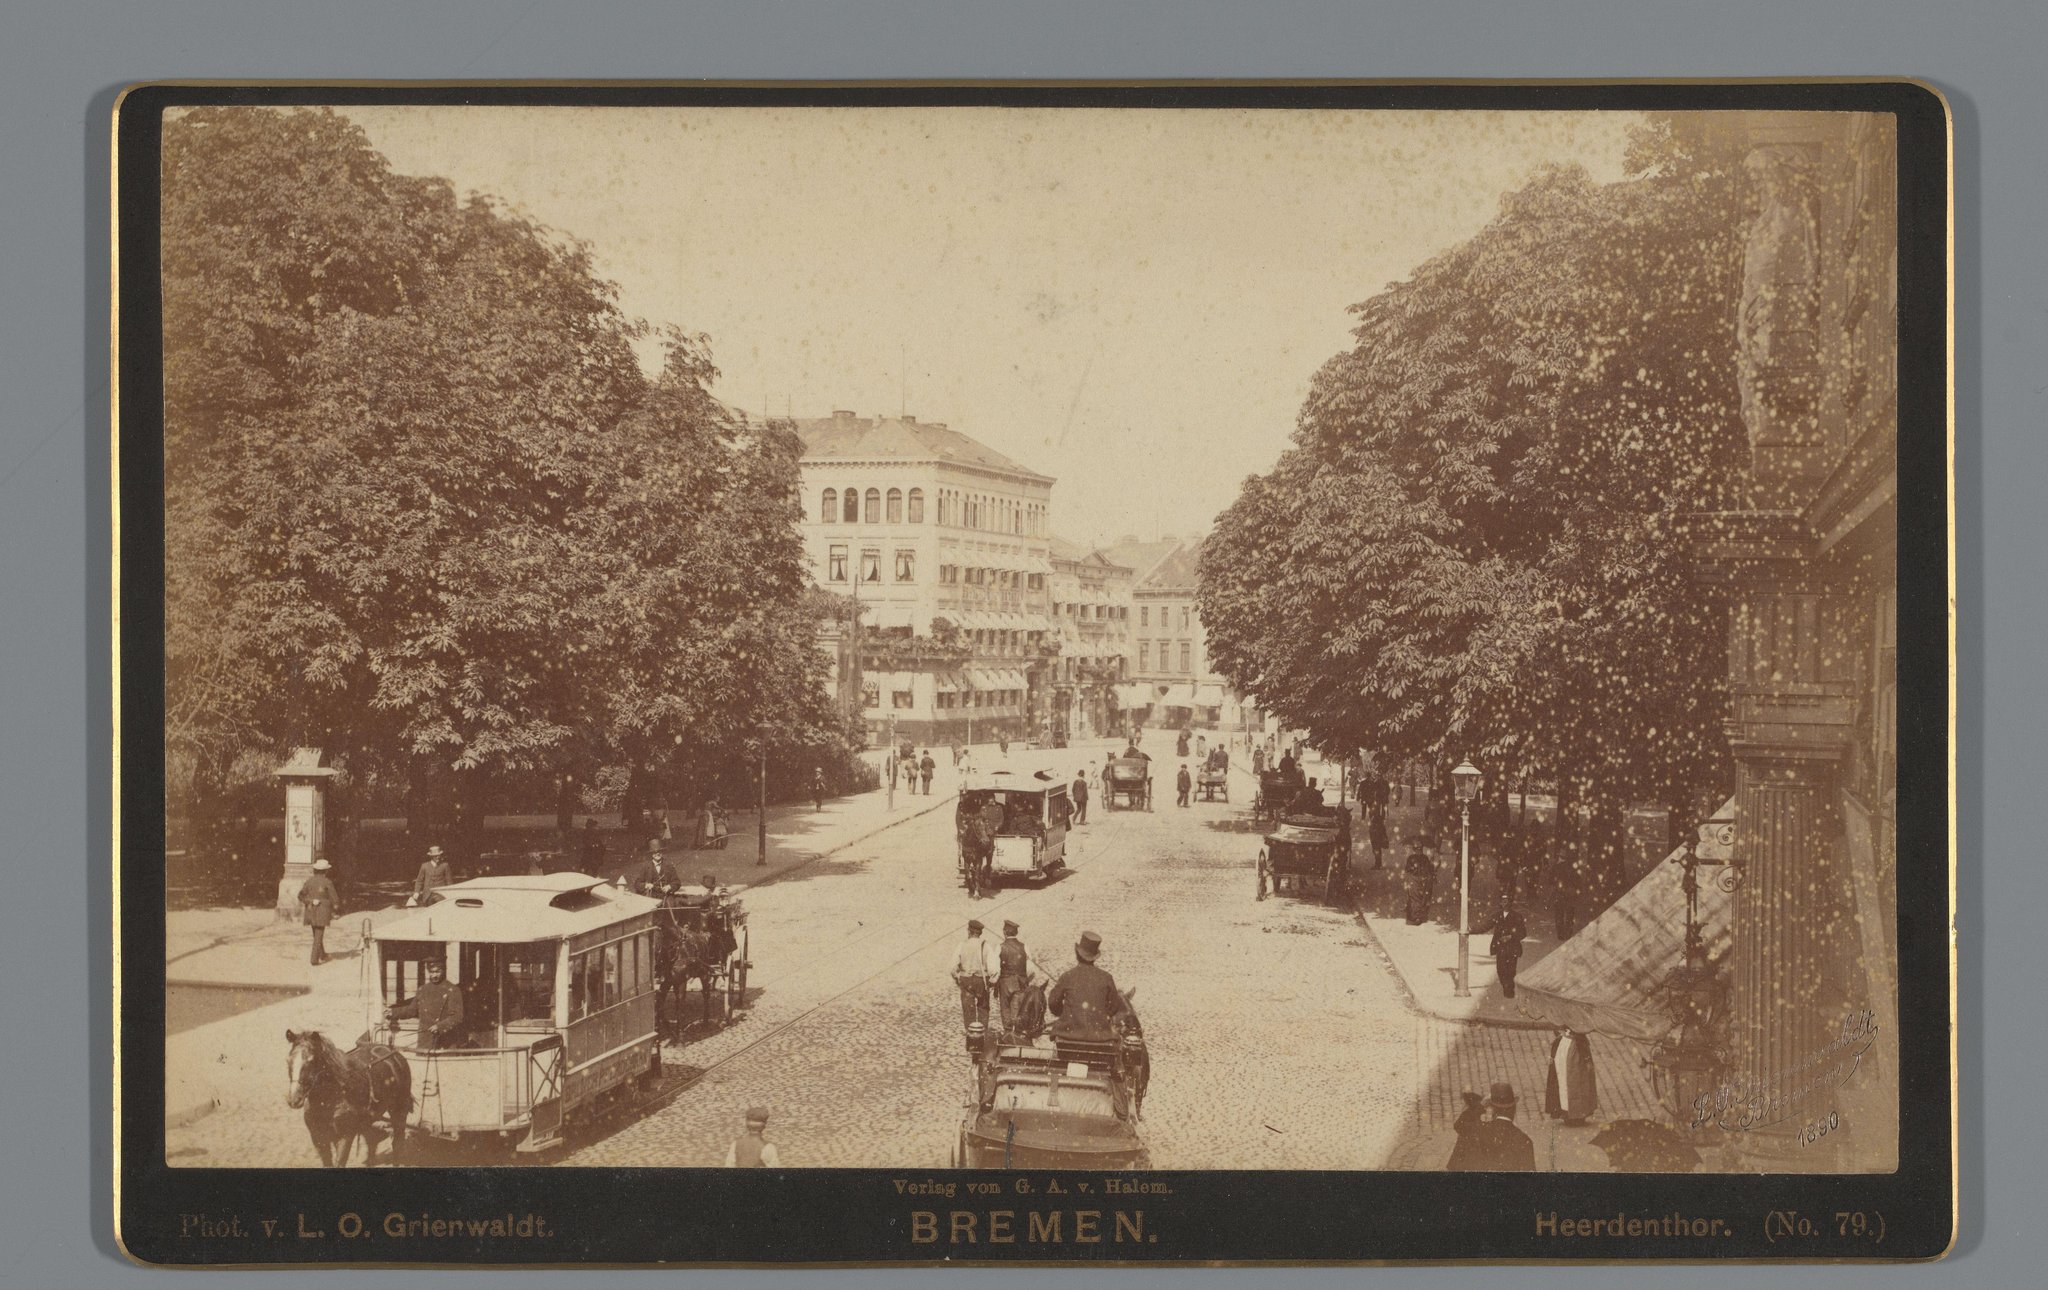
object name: photograph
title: Gezicht op de Heerdenthor in Bremen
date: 1890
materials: cardboard, photographic support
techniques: albumen print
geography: bremen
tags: tramway, tram, street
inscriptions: inscription: ‘Heerdenthor. (No. 79.)’, inscription: ‘L.O. Grienwaldt/ Bremen/ 1890’